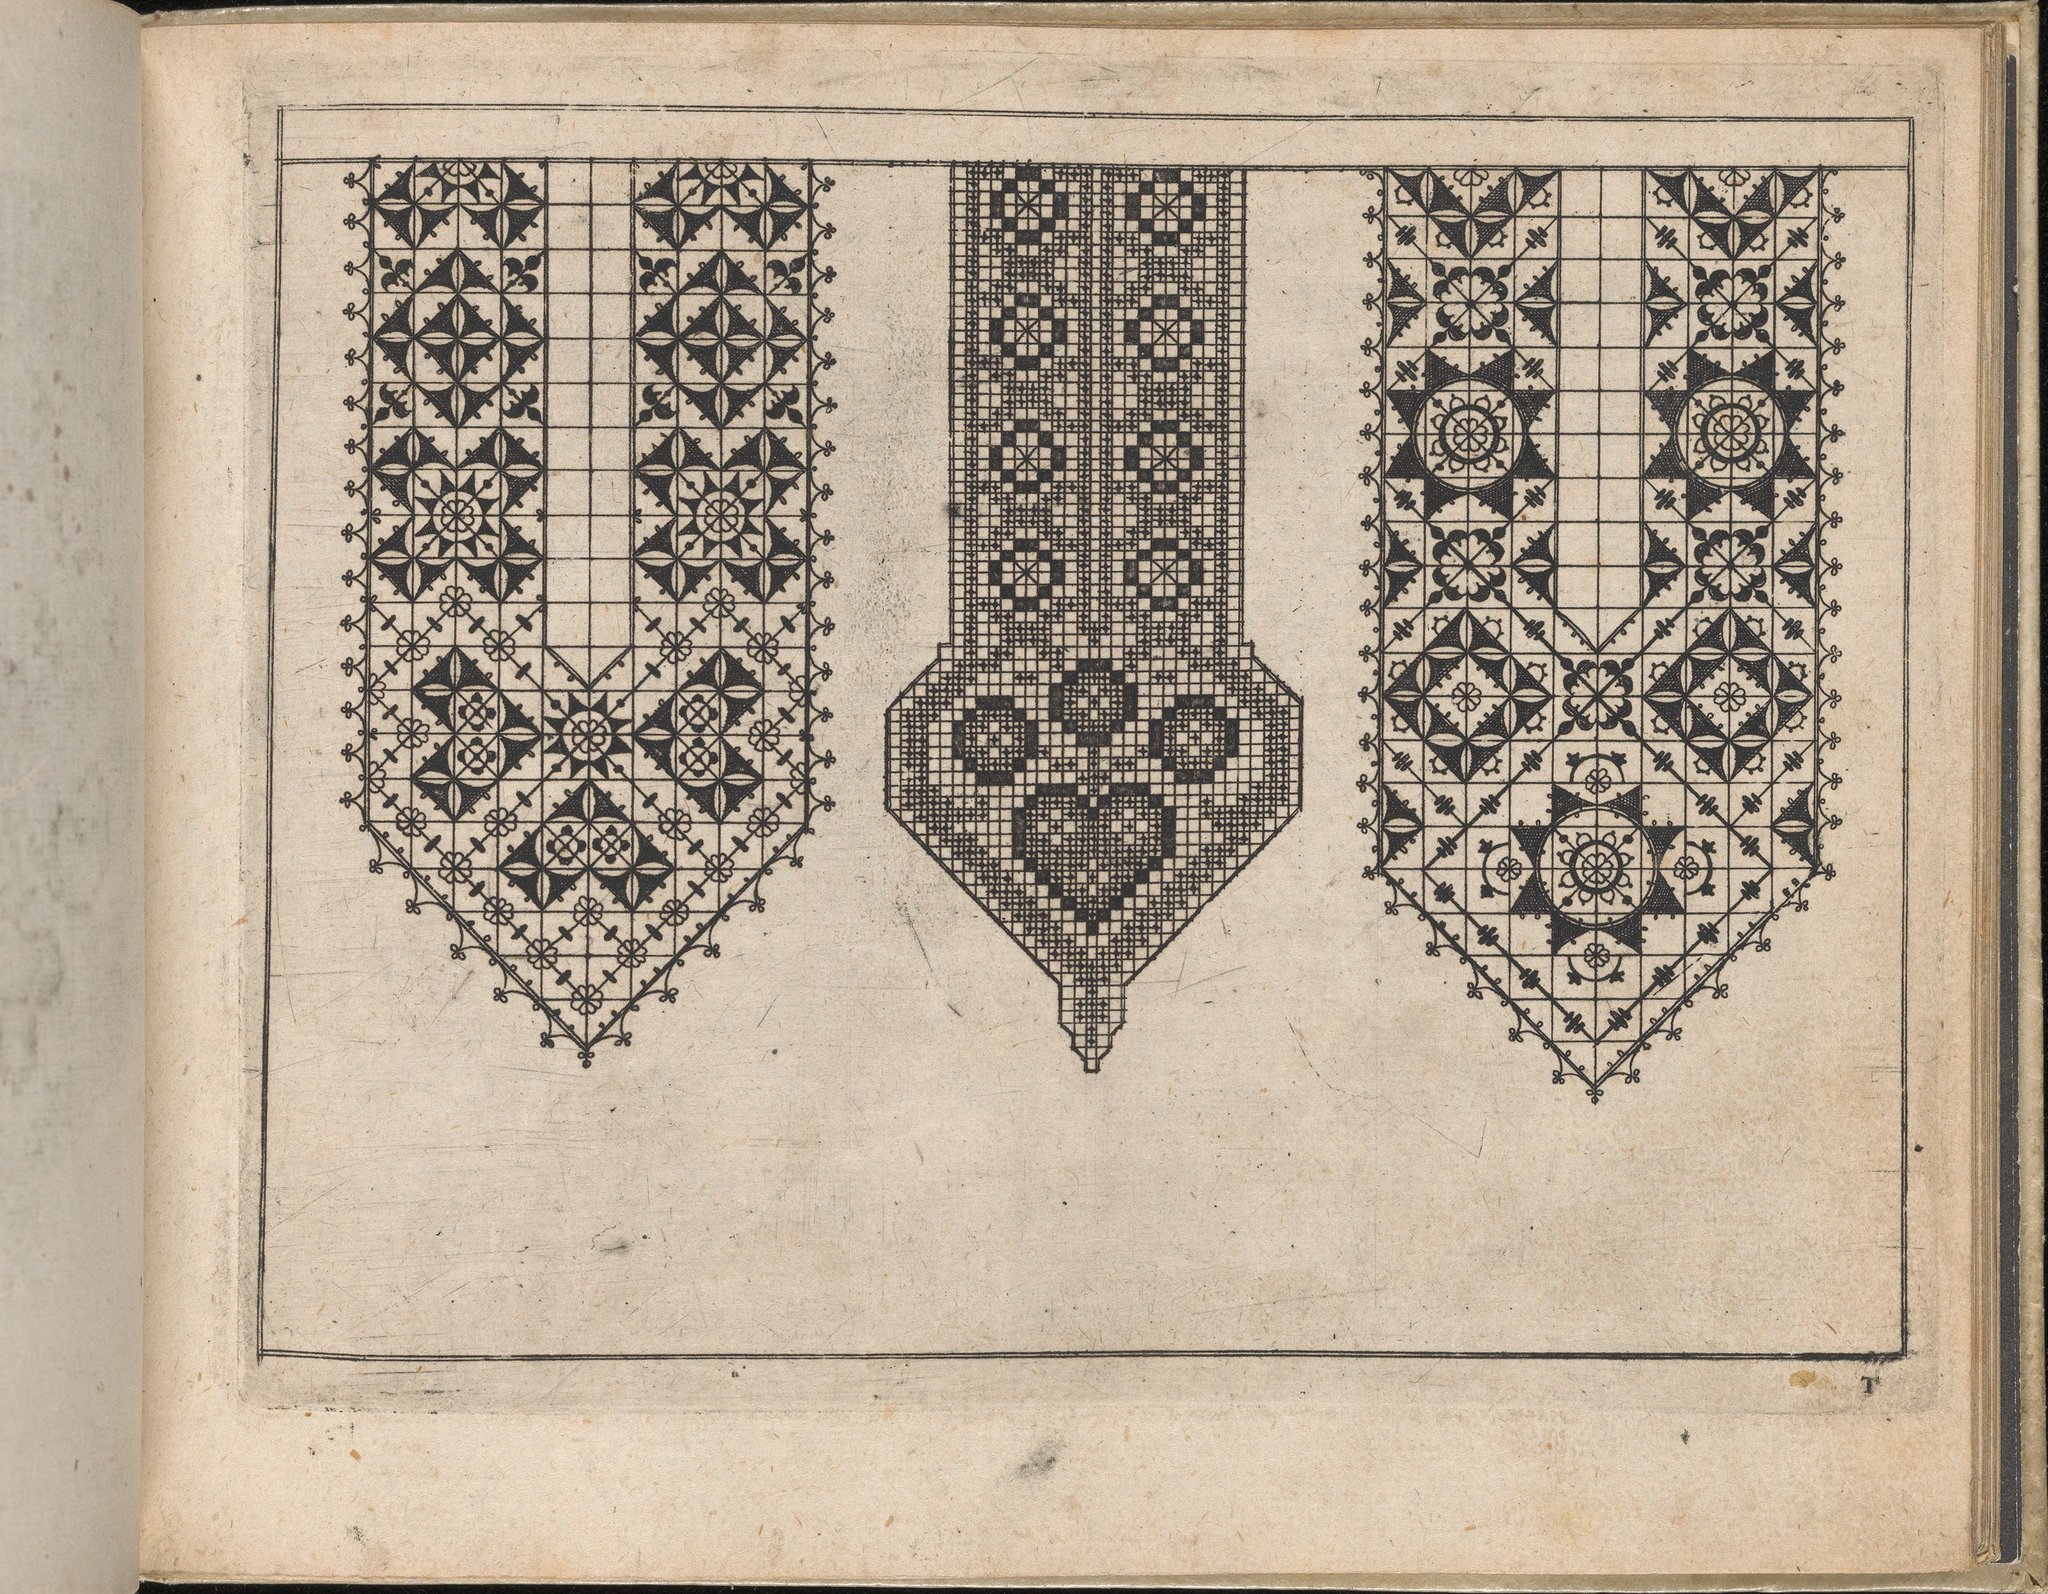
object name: book print ornament architecture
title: Newes Modelbuch in Kupffer (Page 45r)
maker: johann sibmacher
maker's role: artist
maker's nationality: german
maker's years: 1590-1611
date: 1604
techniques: etching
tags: ornament